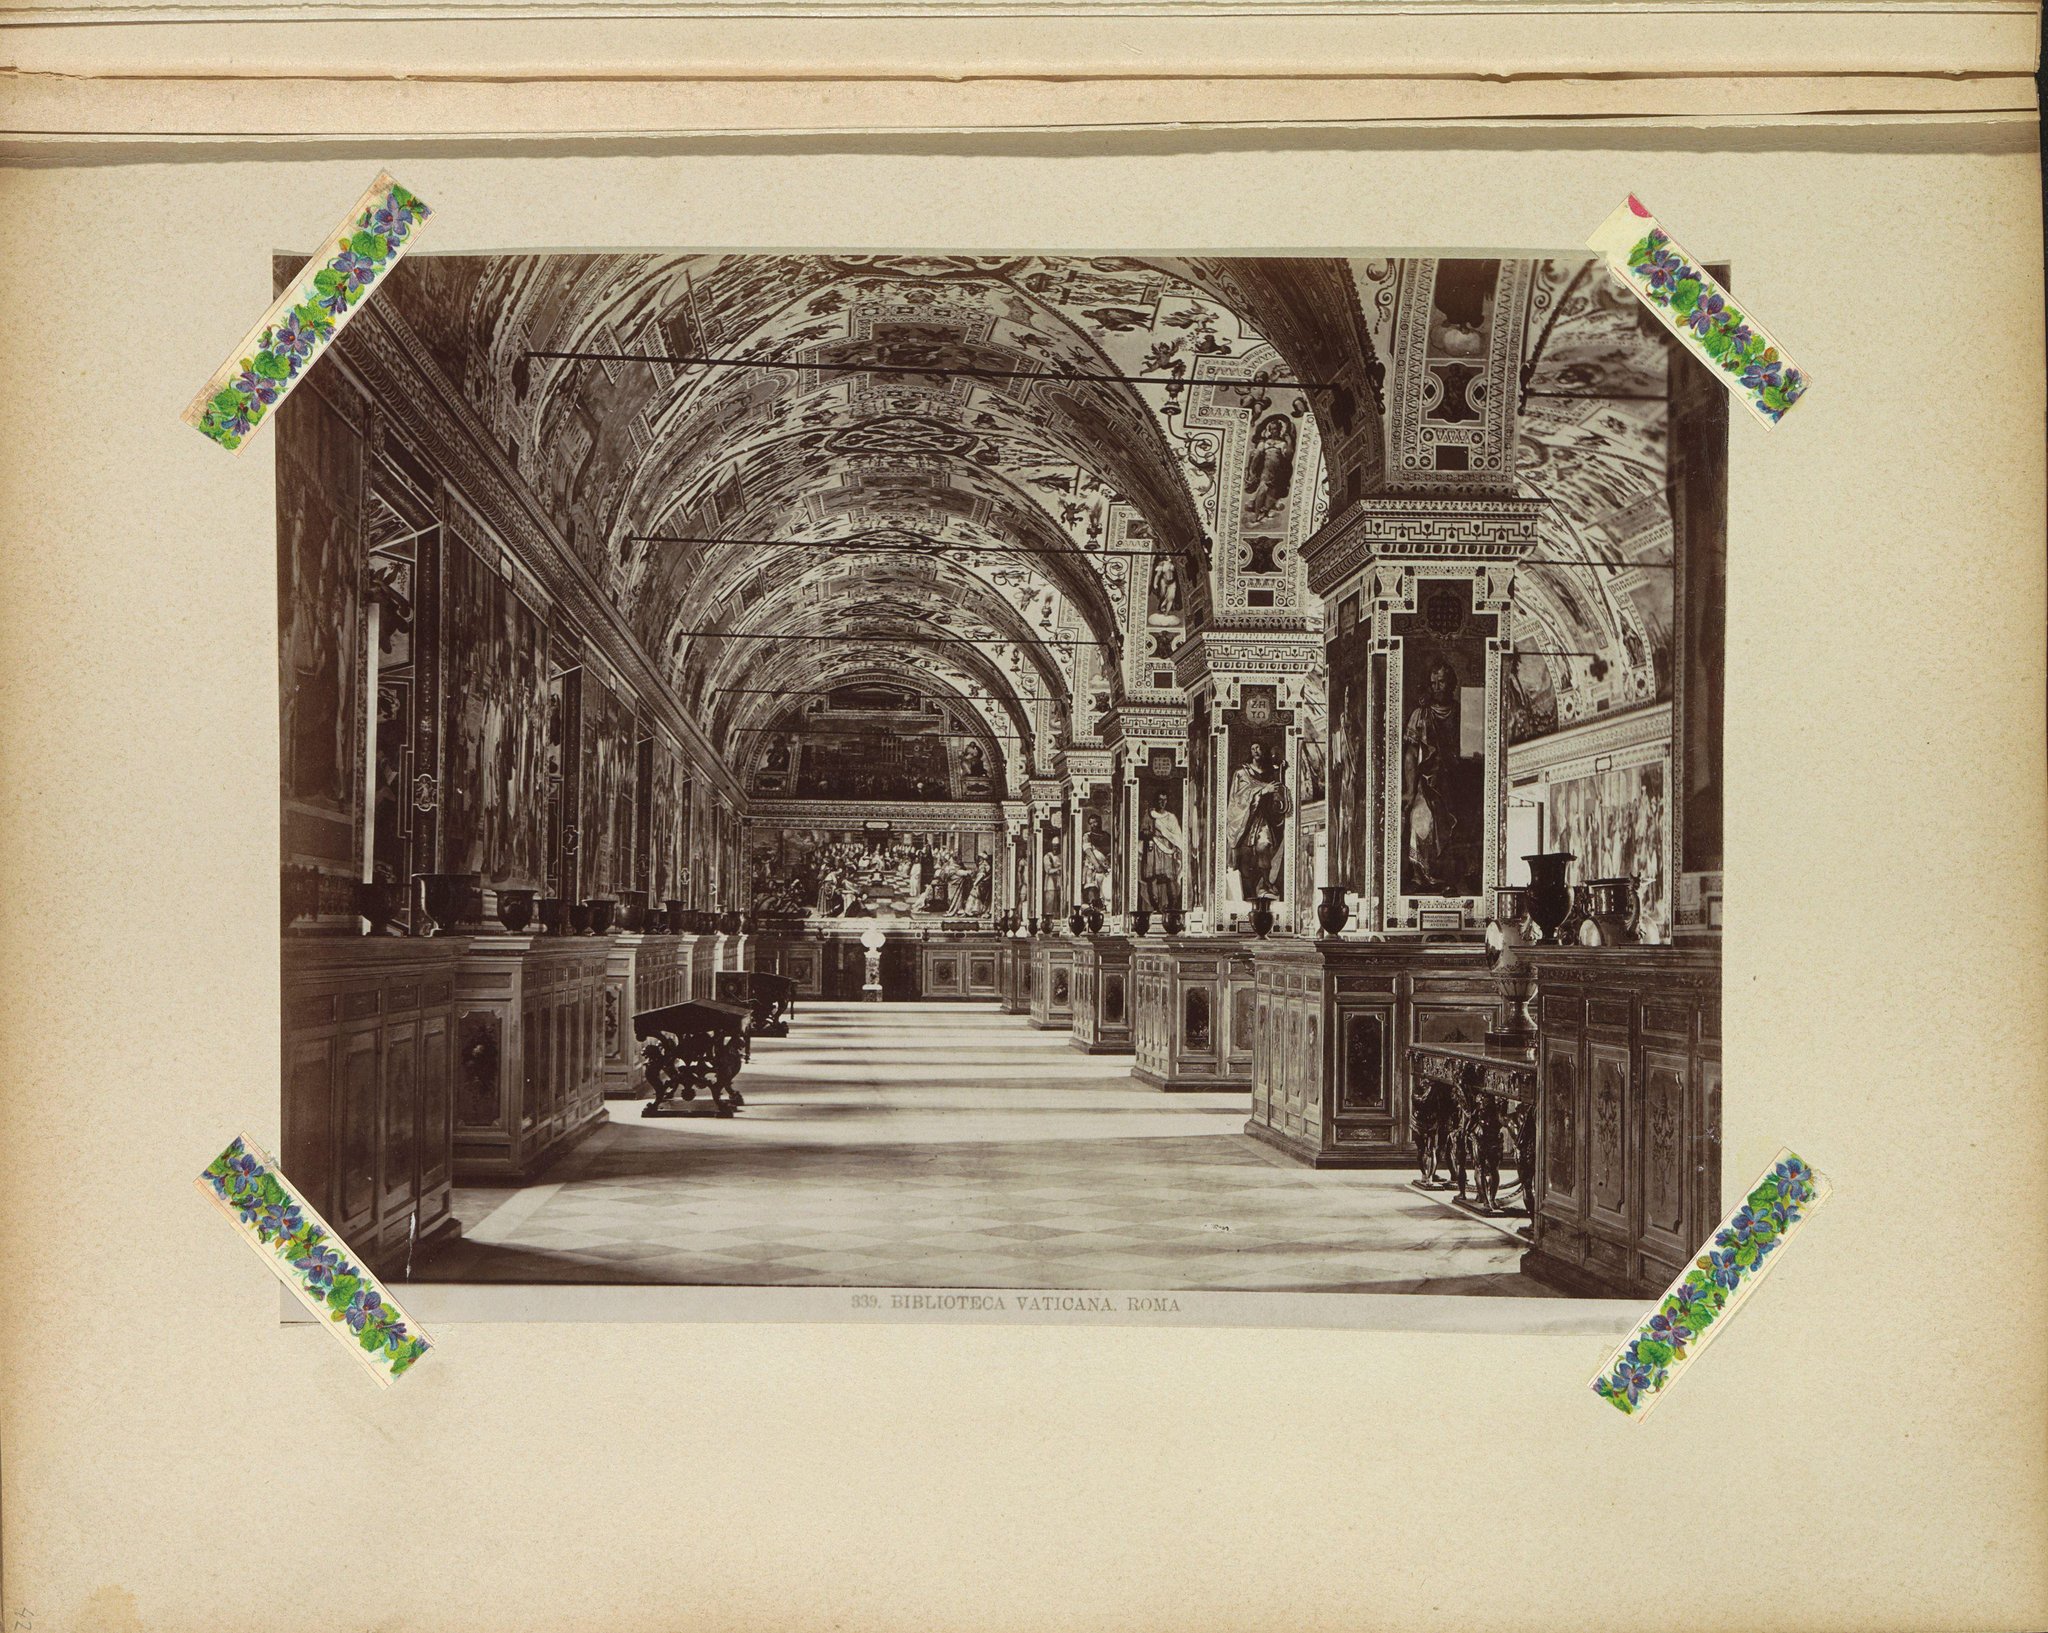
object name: photograph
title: Biblioteca Vaticana. Roma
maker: Anonymous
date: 1860-1900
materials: photographic support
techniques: albumen print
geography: vatican apostolic library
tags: public library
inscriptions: number: ‘339’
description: Onderdeel van Fotoalbum met opnames van bezienswaardigheden in Italiaanse steden en van kunstwerken.